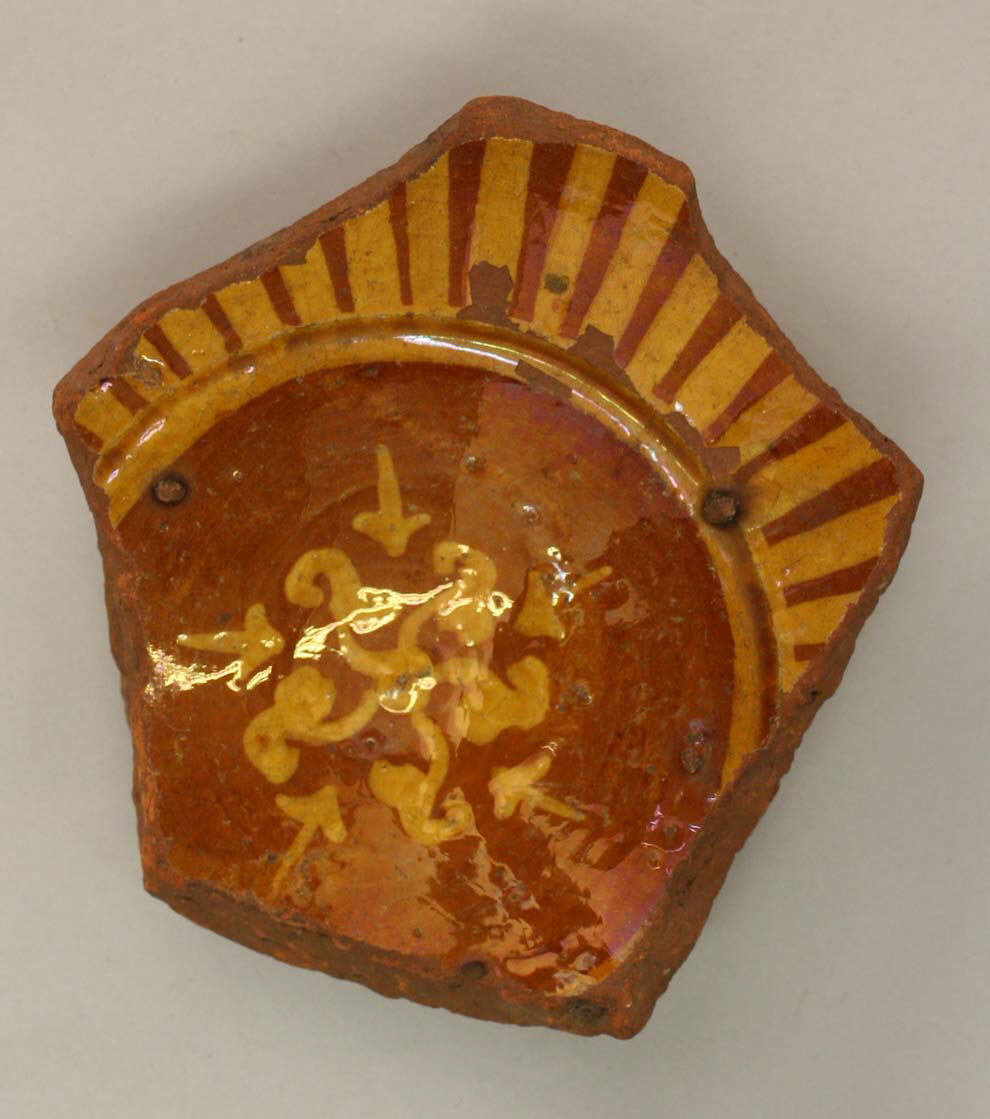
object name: fragment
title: Fragment of a Bowl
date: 1301-1500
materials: earthenware, glaze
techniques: painting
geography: egypt